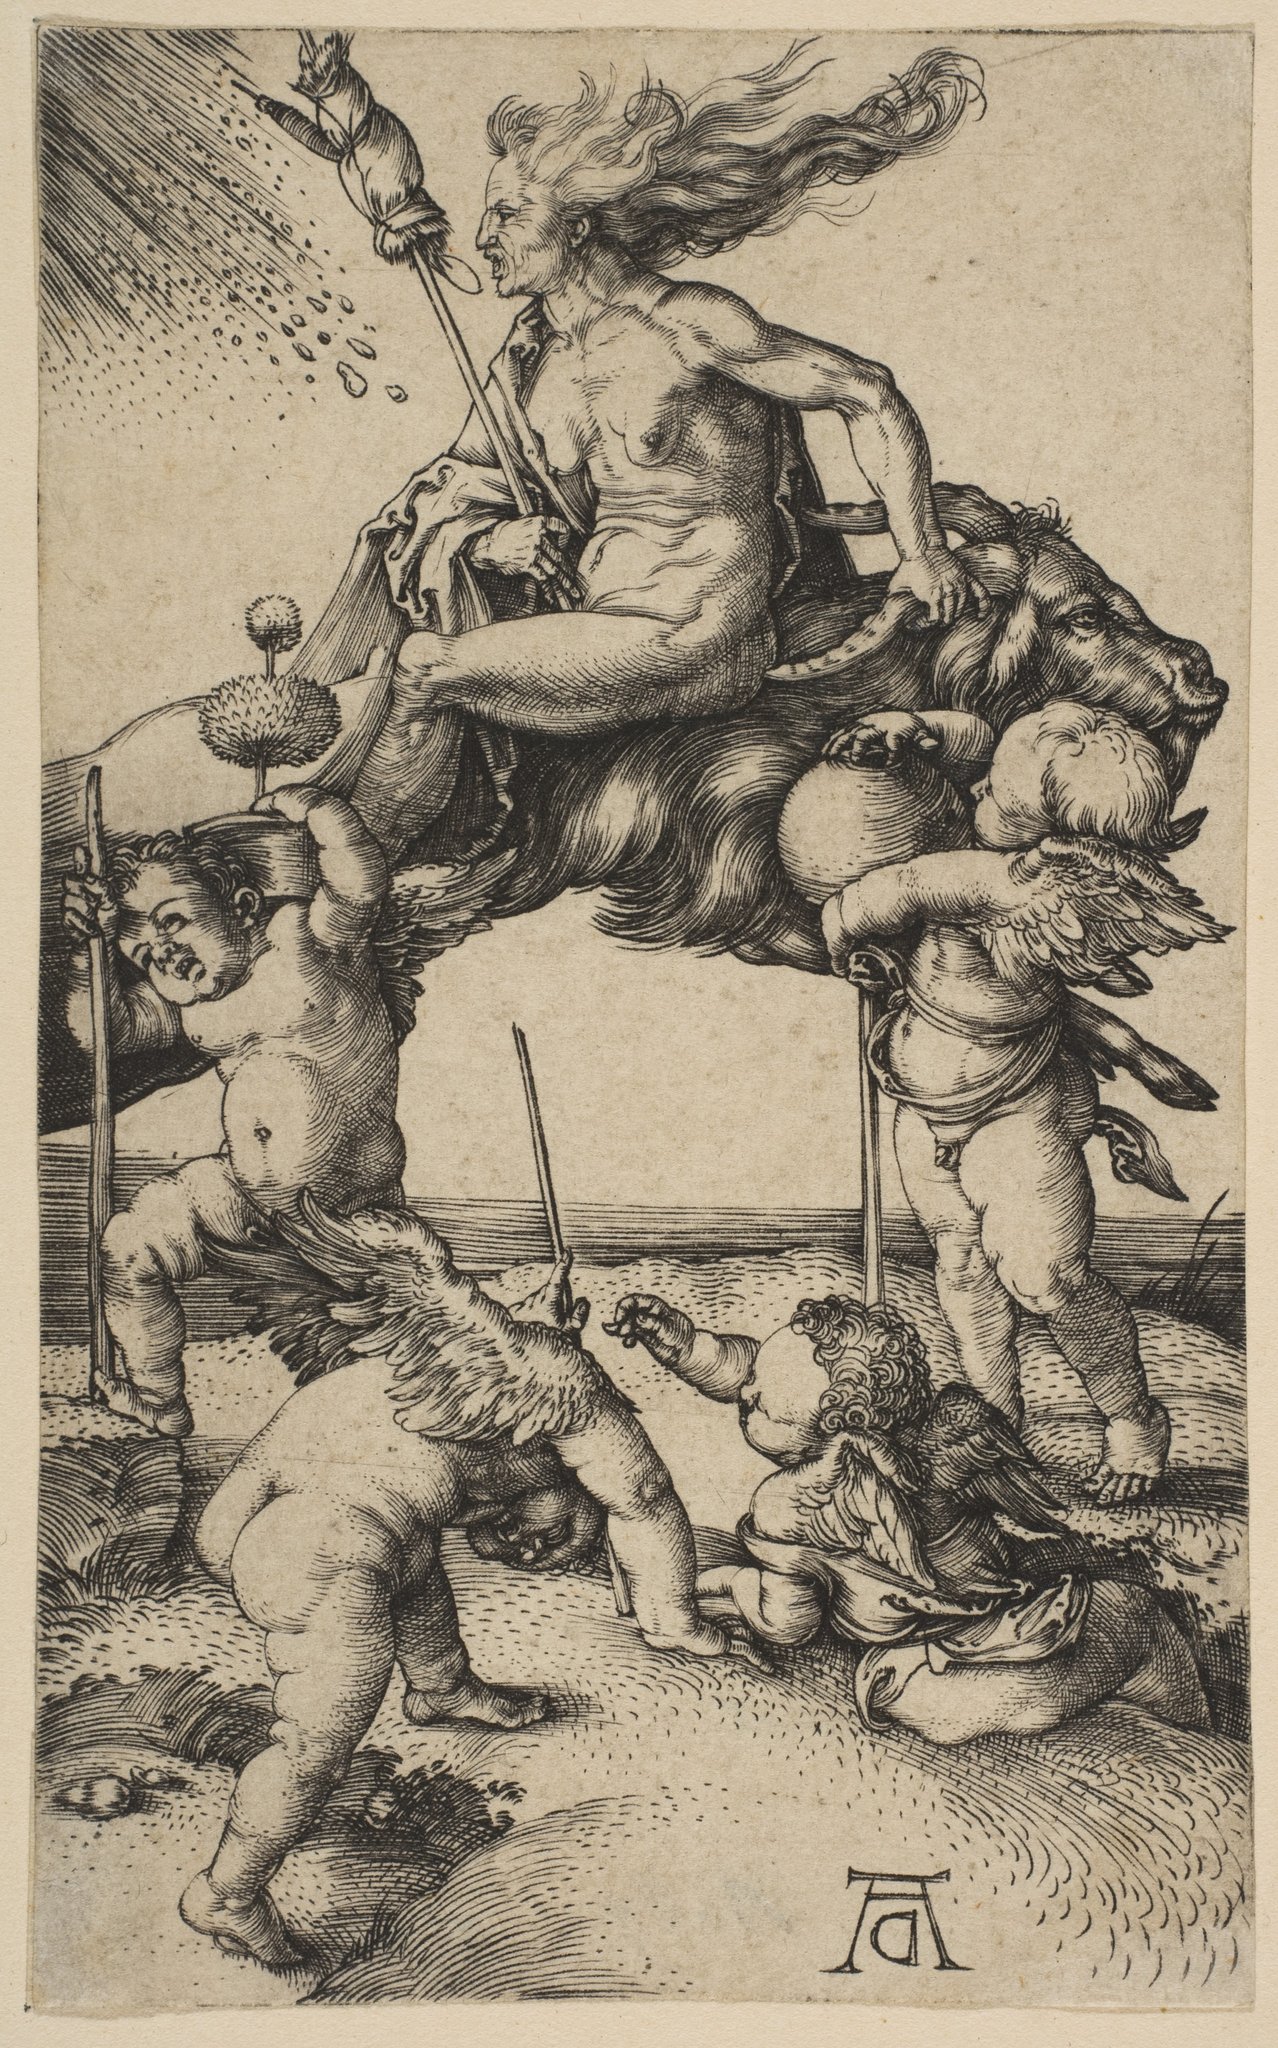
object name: print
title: The Witch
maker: albrecht dürer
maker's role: artist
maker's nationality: german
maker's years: 1471-1528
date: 1500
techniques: engraving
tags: female nudes,putti,goats,witches